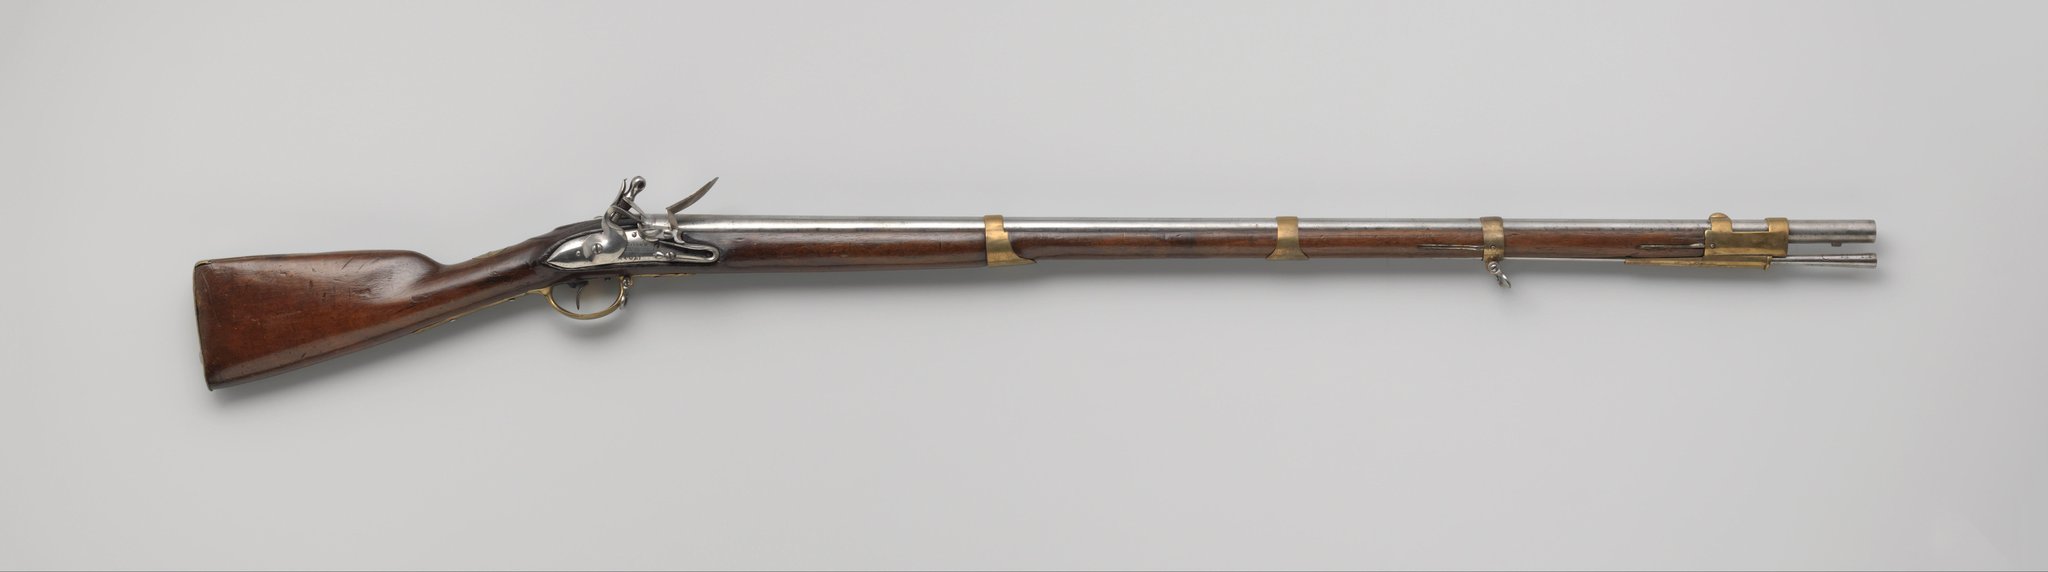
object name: flintlock pistol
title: Vuursteengeweer voor de Schutterij Harlingen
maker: lambertus michaelis thone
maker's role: weapon manufacturer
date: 1780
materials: brass, iron, steel, wood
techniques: printing, cutting, engraving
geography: amsterdam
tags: harlingen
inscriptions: : ‘7 q H (of M)//HARLINGEN//N=8’, signature: ‘THONE // AMSTERDAM’, mark, : ‘CN (de N in superscript) No. :44’, coat of arms, inscription: ‘A 1621’, : ‘D.III of D.m.’